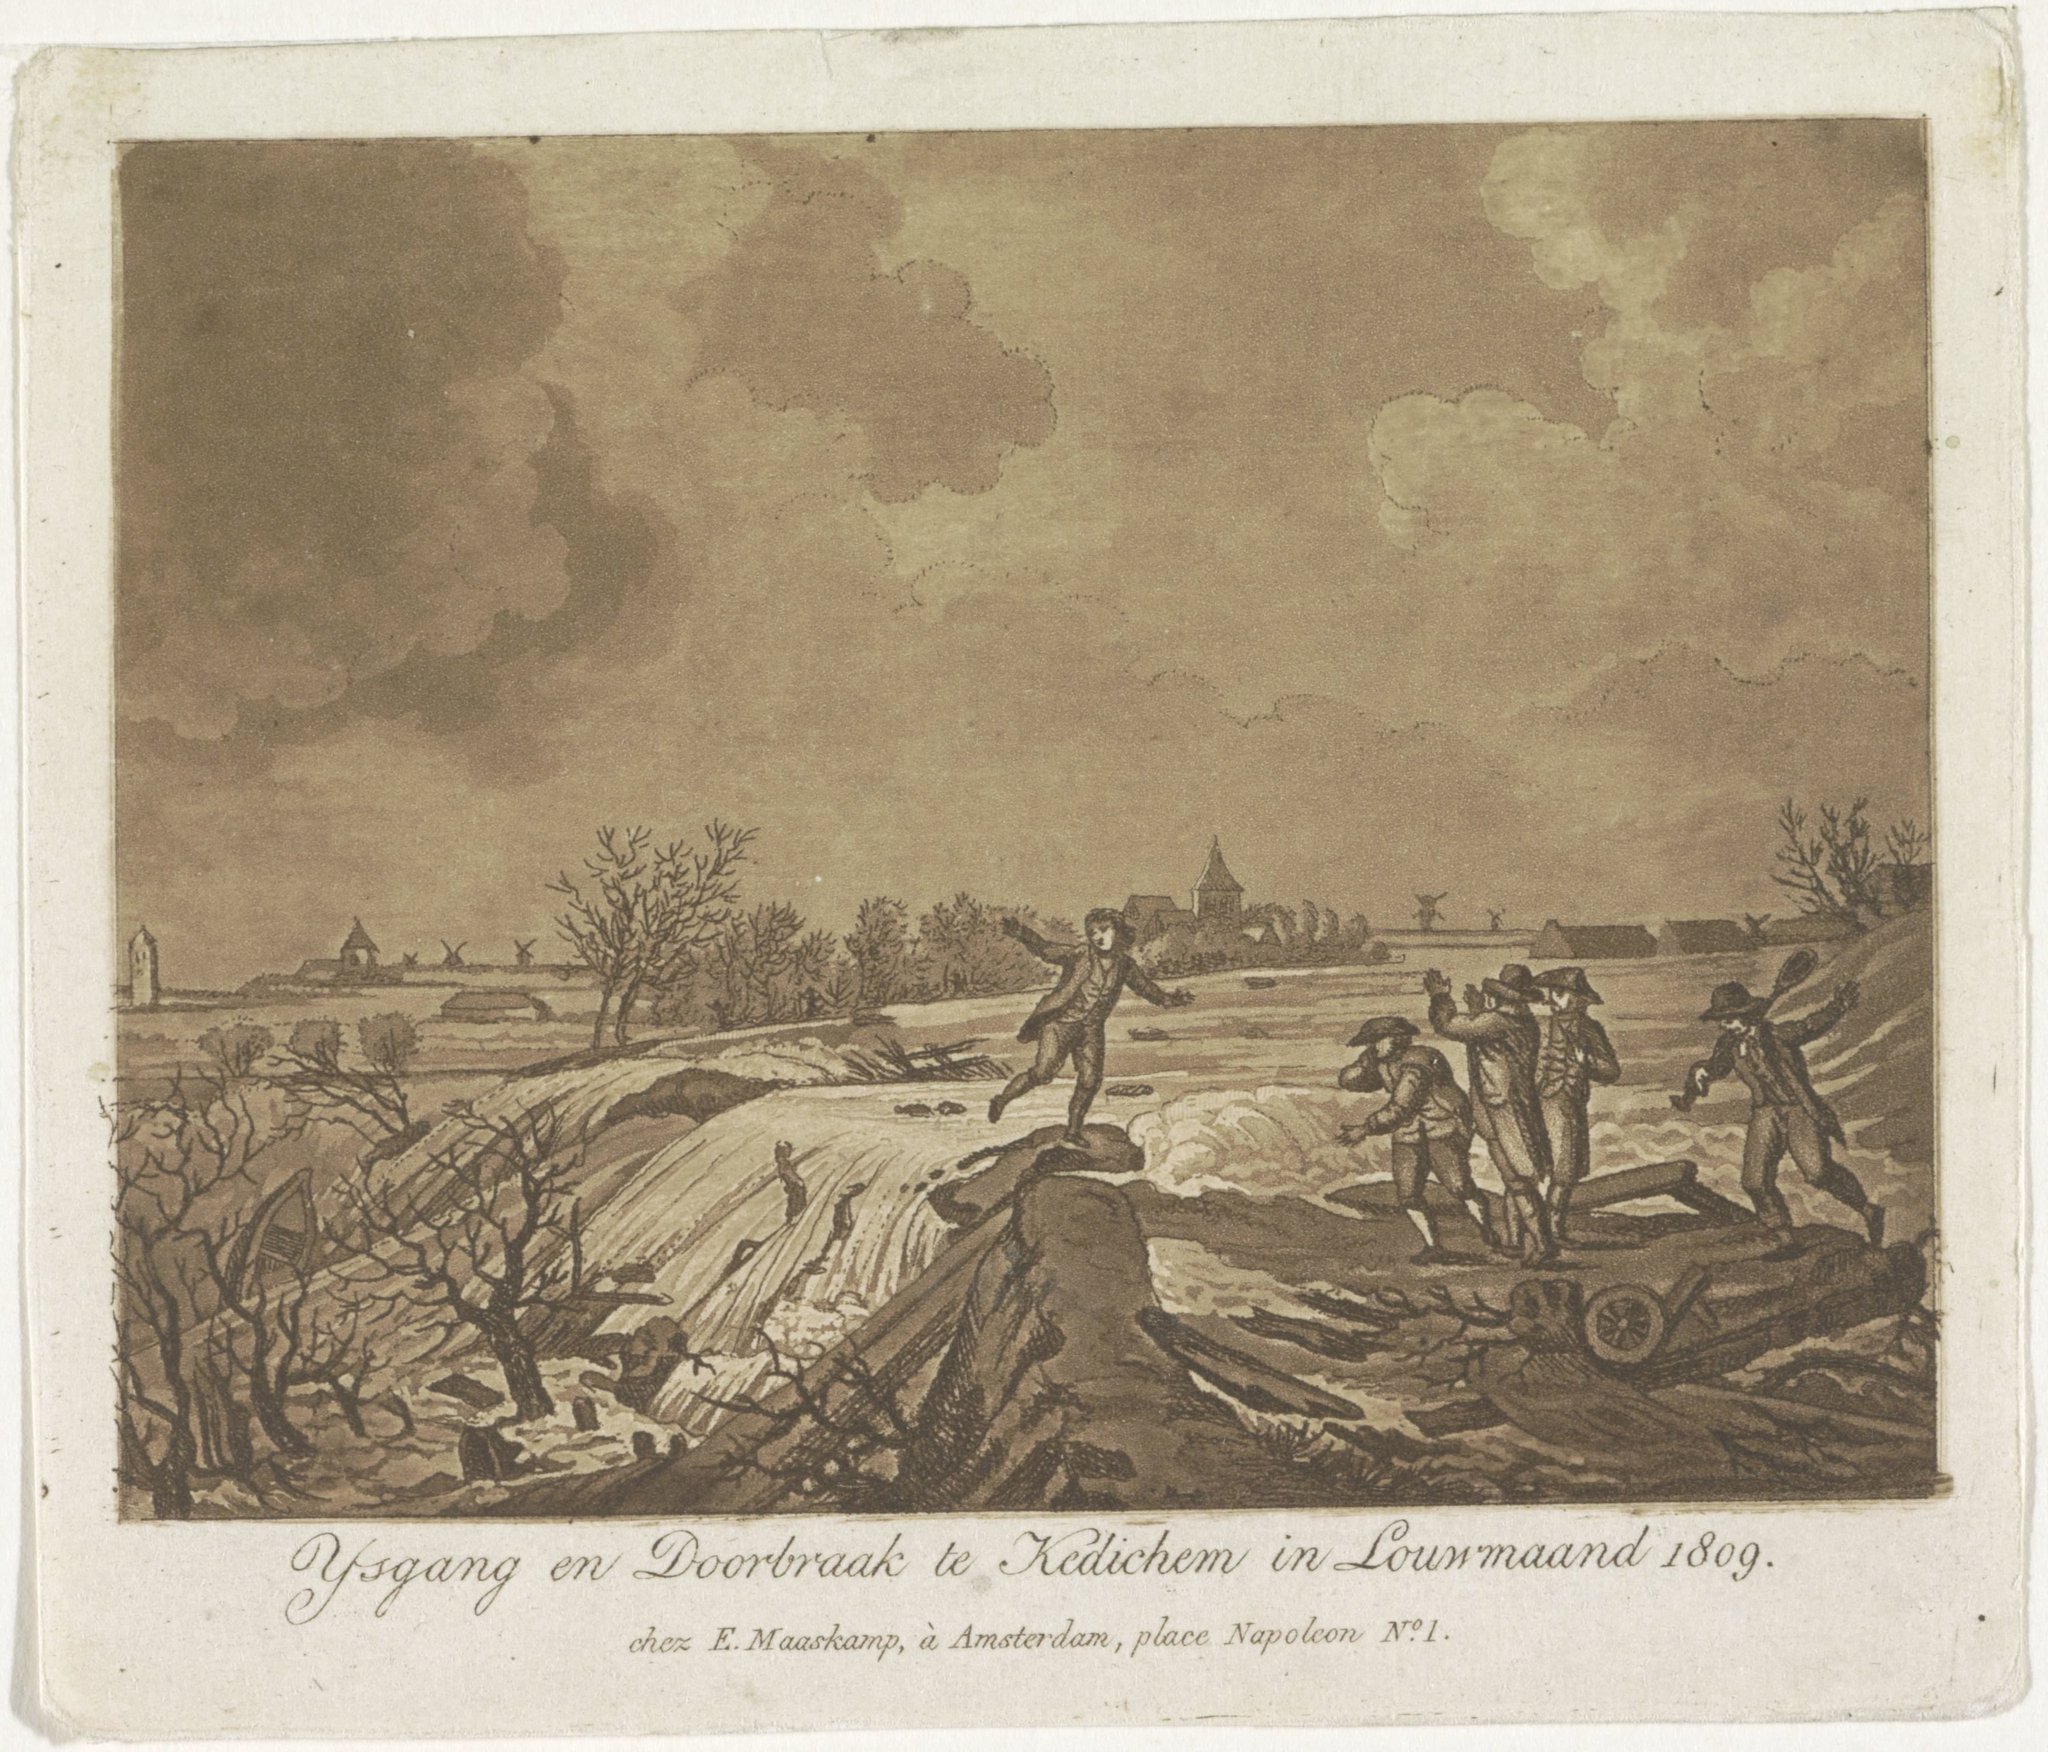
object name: print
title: Dijkdoorbraak te Kedichem, 1809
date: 1816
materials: paper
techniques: aquatint, etching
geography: netherlands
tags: dike-break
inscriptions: collector's mark: Lugt 2228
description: Waarschijnlijk gebruikt als illustratie in: Merkwaardige gezigten, gebouwen, monumenten en standbeelden in de Noordelijke provintiën van het Koningrijk der Nederlanden = Vues remarquables, édifices, monumens et statues dans les provinces septentrionales du Royaume des Pays-Bas. Amsterdam: Evert Maaskamp, 1816. Verkleinde kopie naar de prent van R. Vinkeles naar C. van Hardenbergh, zie FMH 5754a/5.